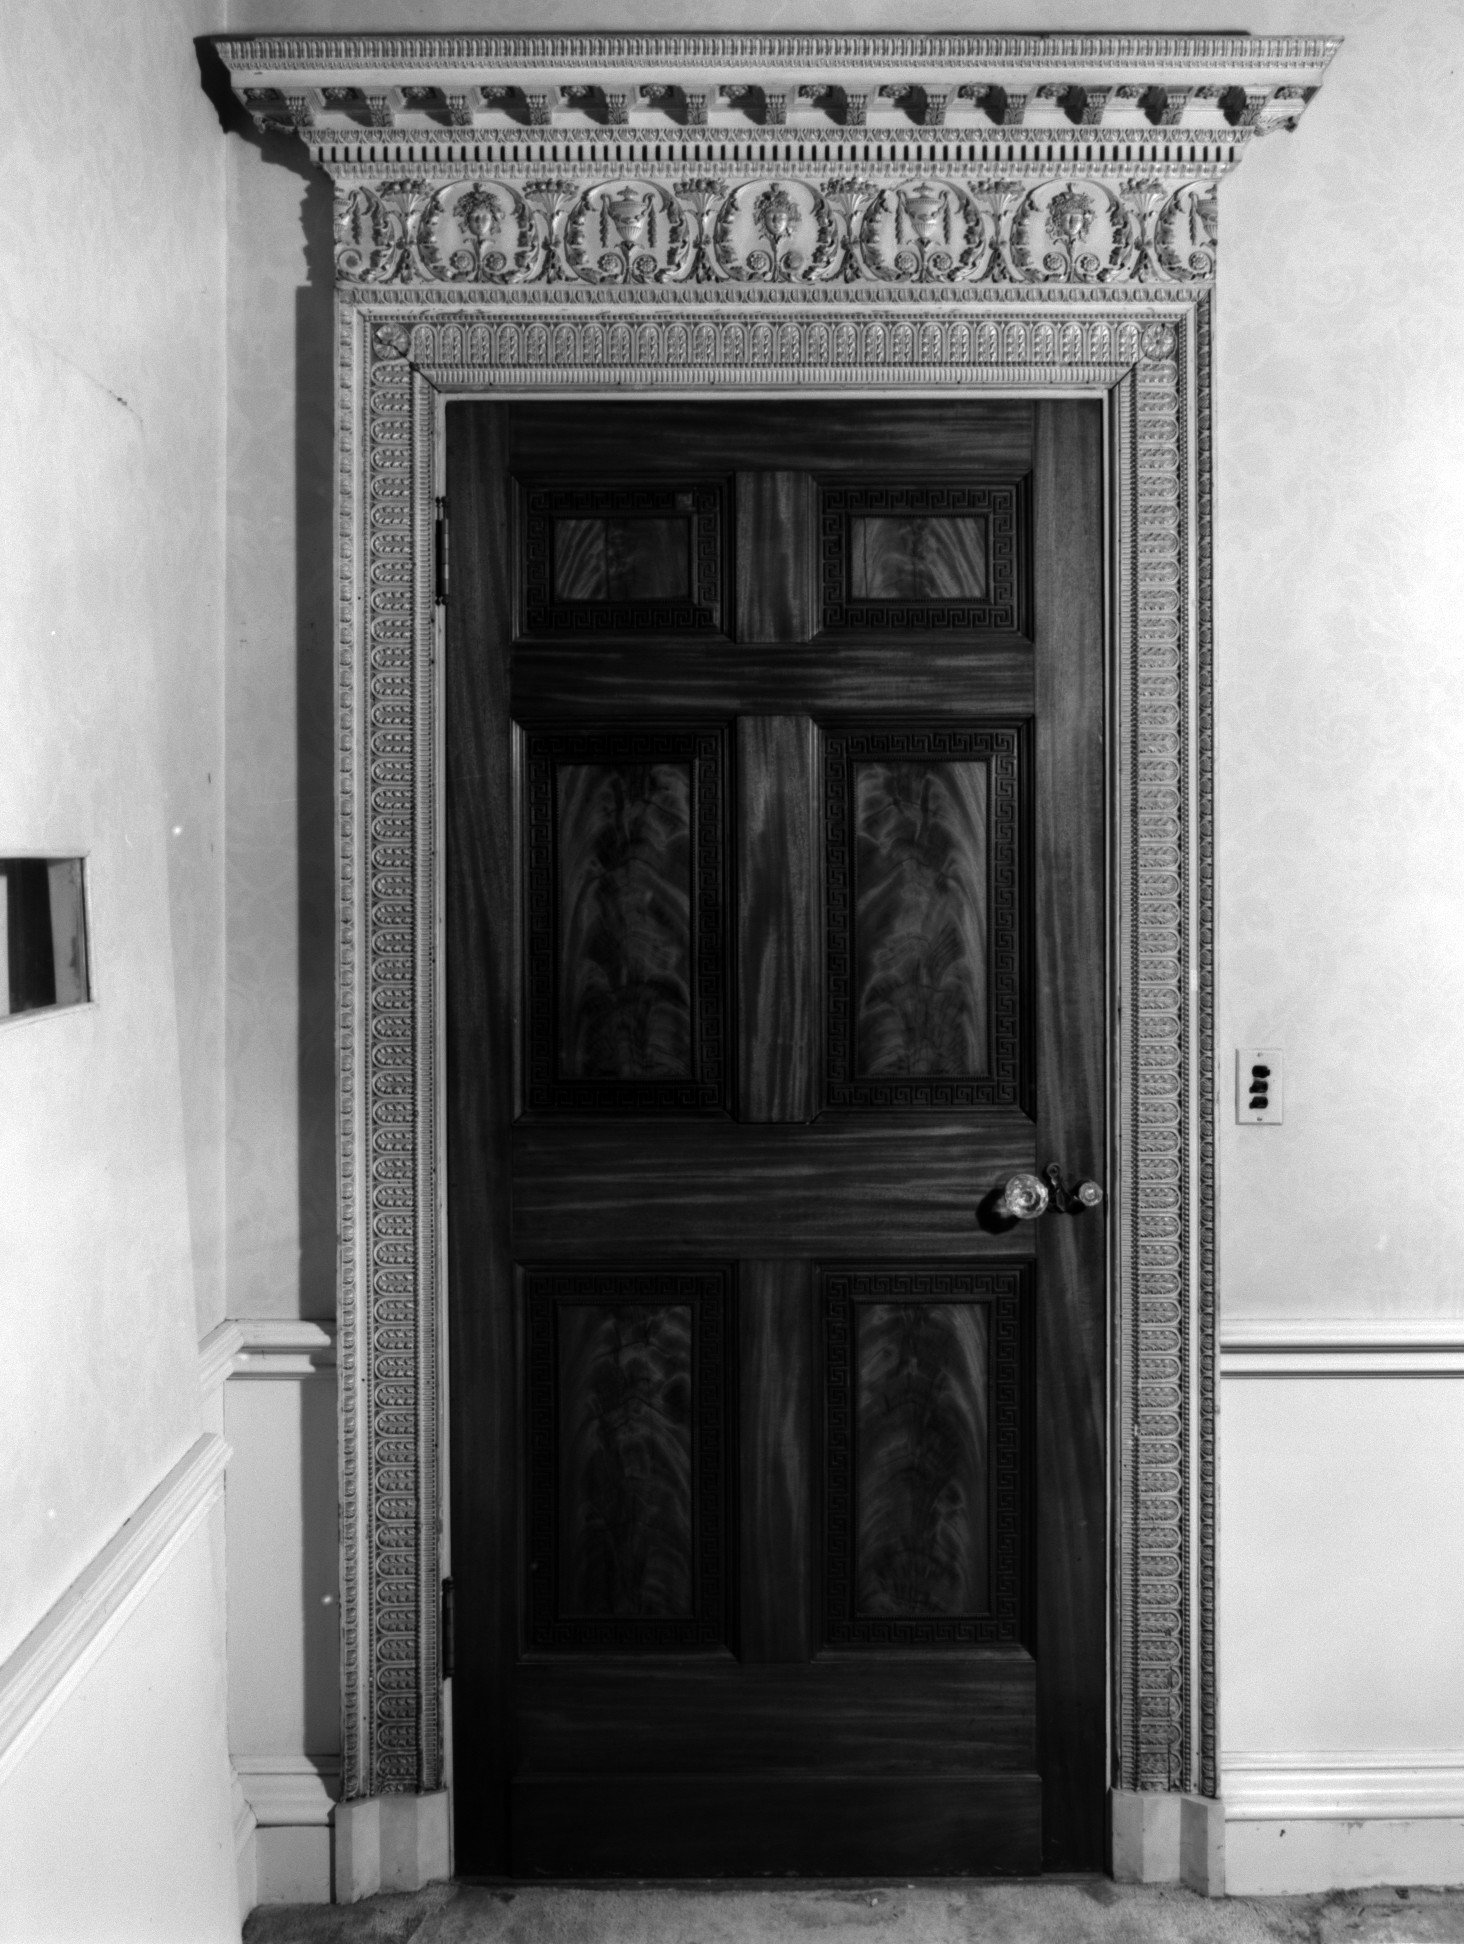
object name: doorway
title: Doorway (one of a pair)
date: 1776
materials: gilt, wood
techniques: painting